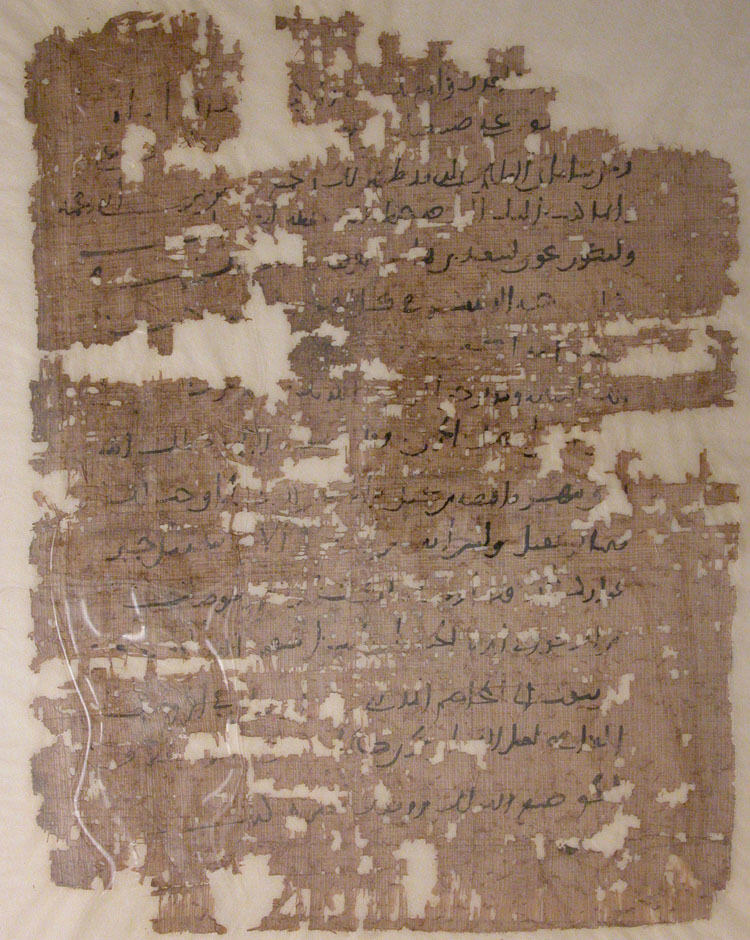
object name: non illustrated single work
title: Fragment of a Letter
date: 701-900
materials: ink, papyrus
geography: egypt